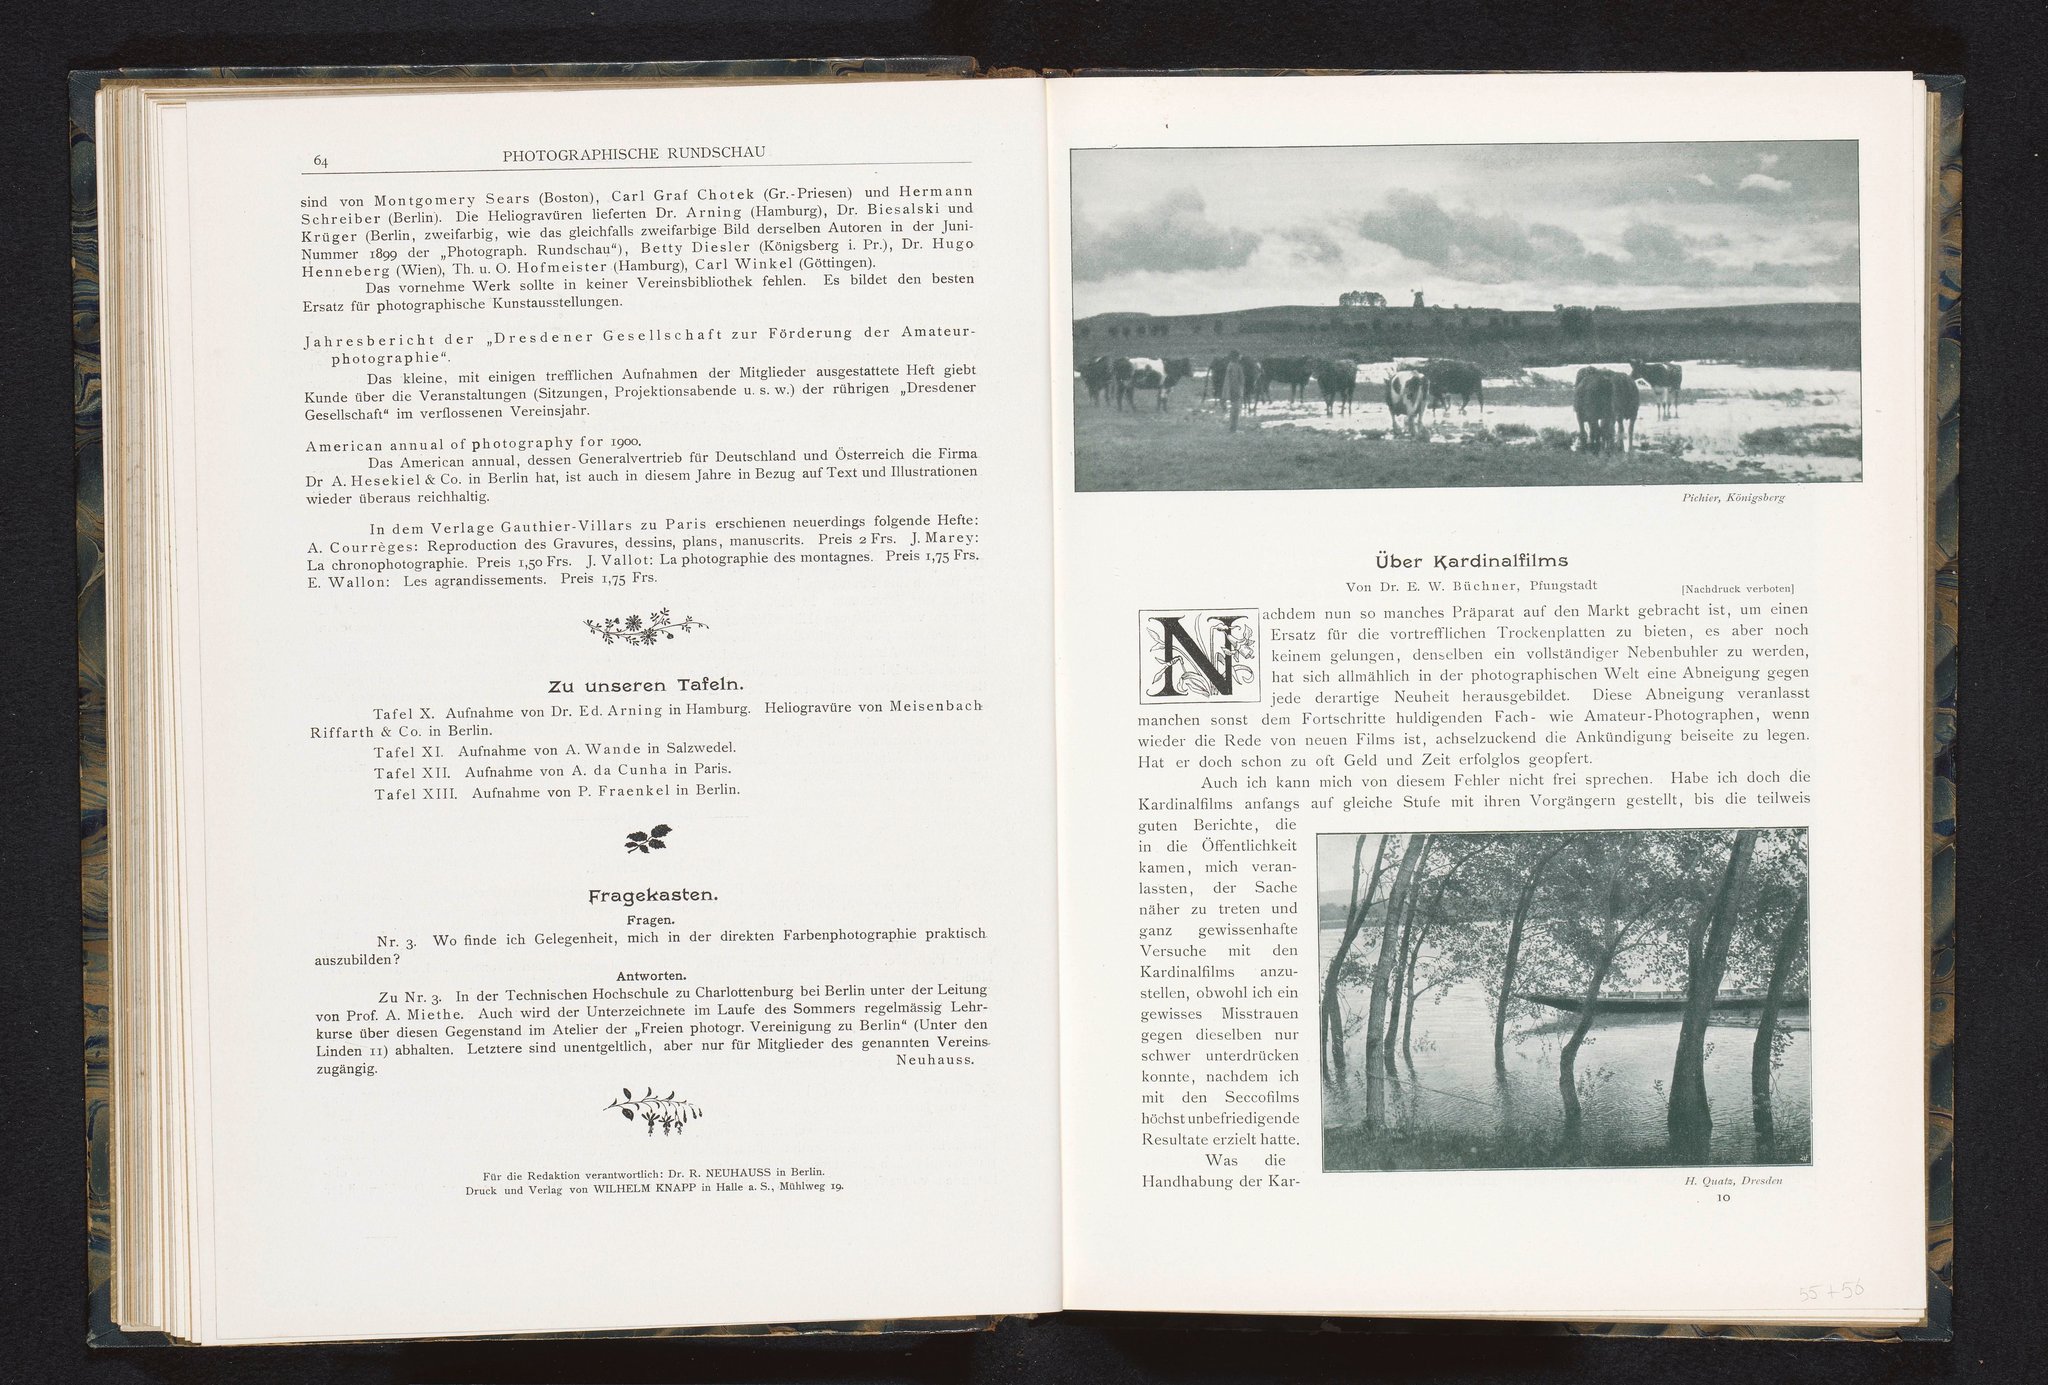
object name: photomechanical print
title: Gezicht op een boot in het water en bomen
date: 1895-1900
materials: paper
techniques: autotype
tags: trees, landscapes with waters, waterscapes, seascapes (in the temperate zone), rowing-boat, canoe, etc.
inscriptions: monogram: ‘WC’